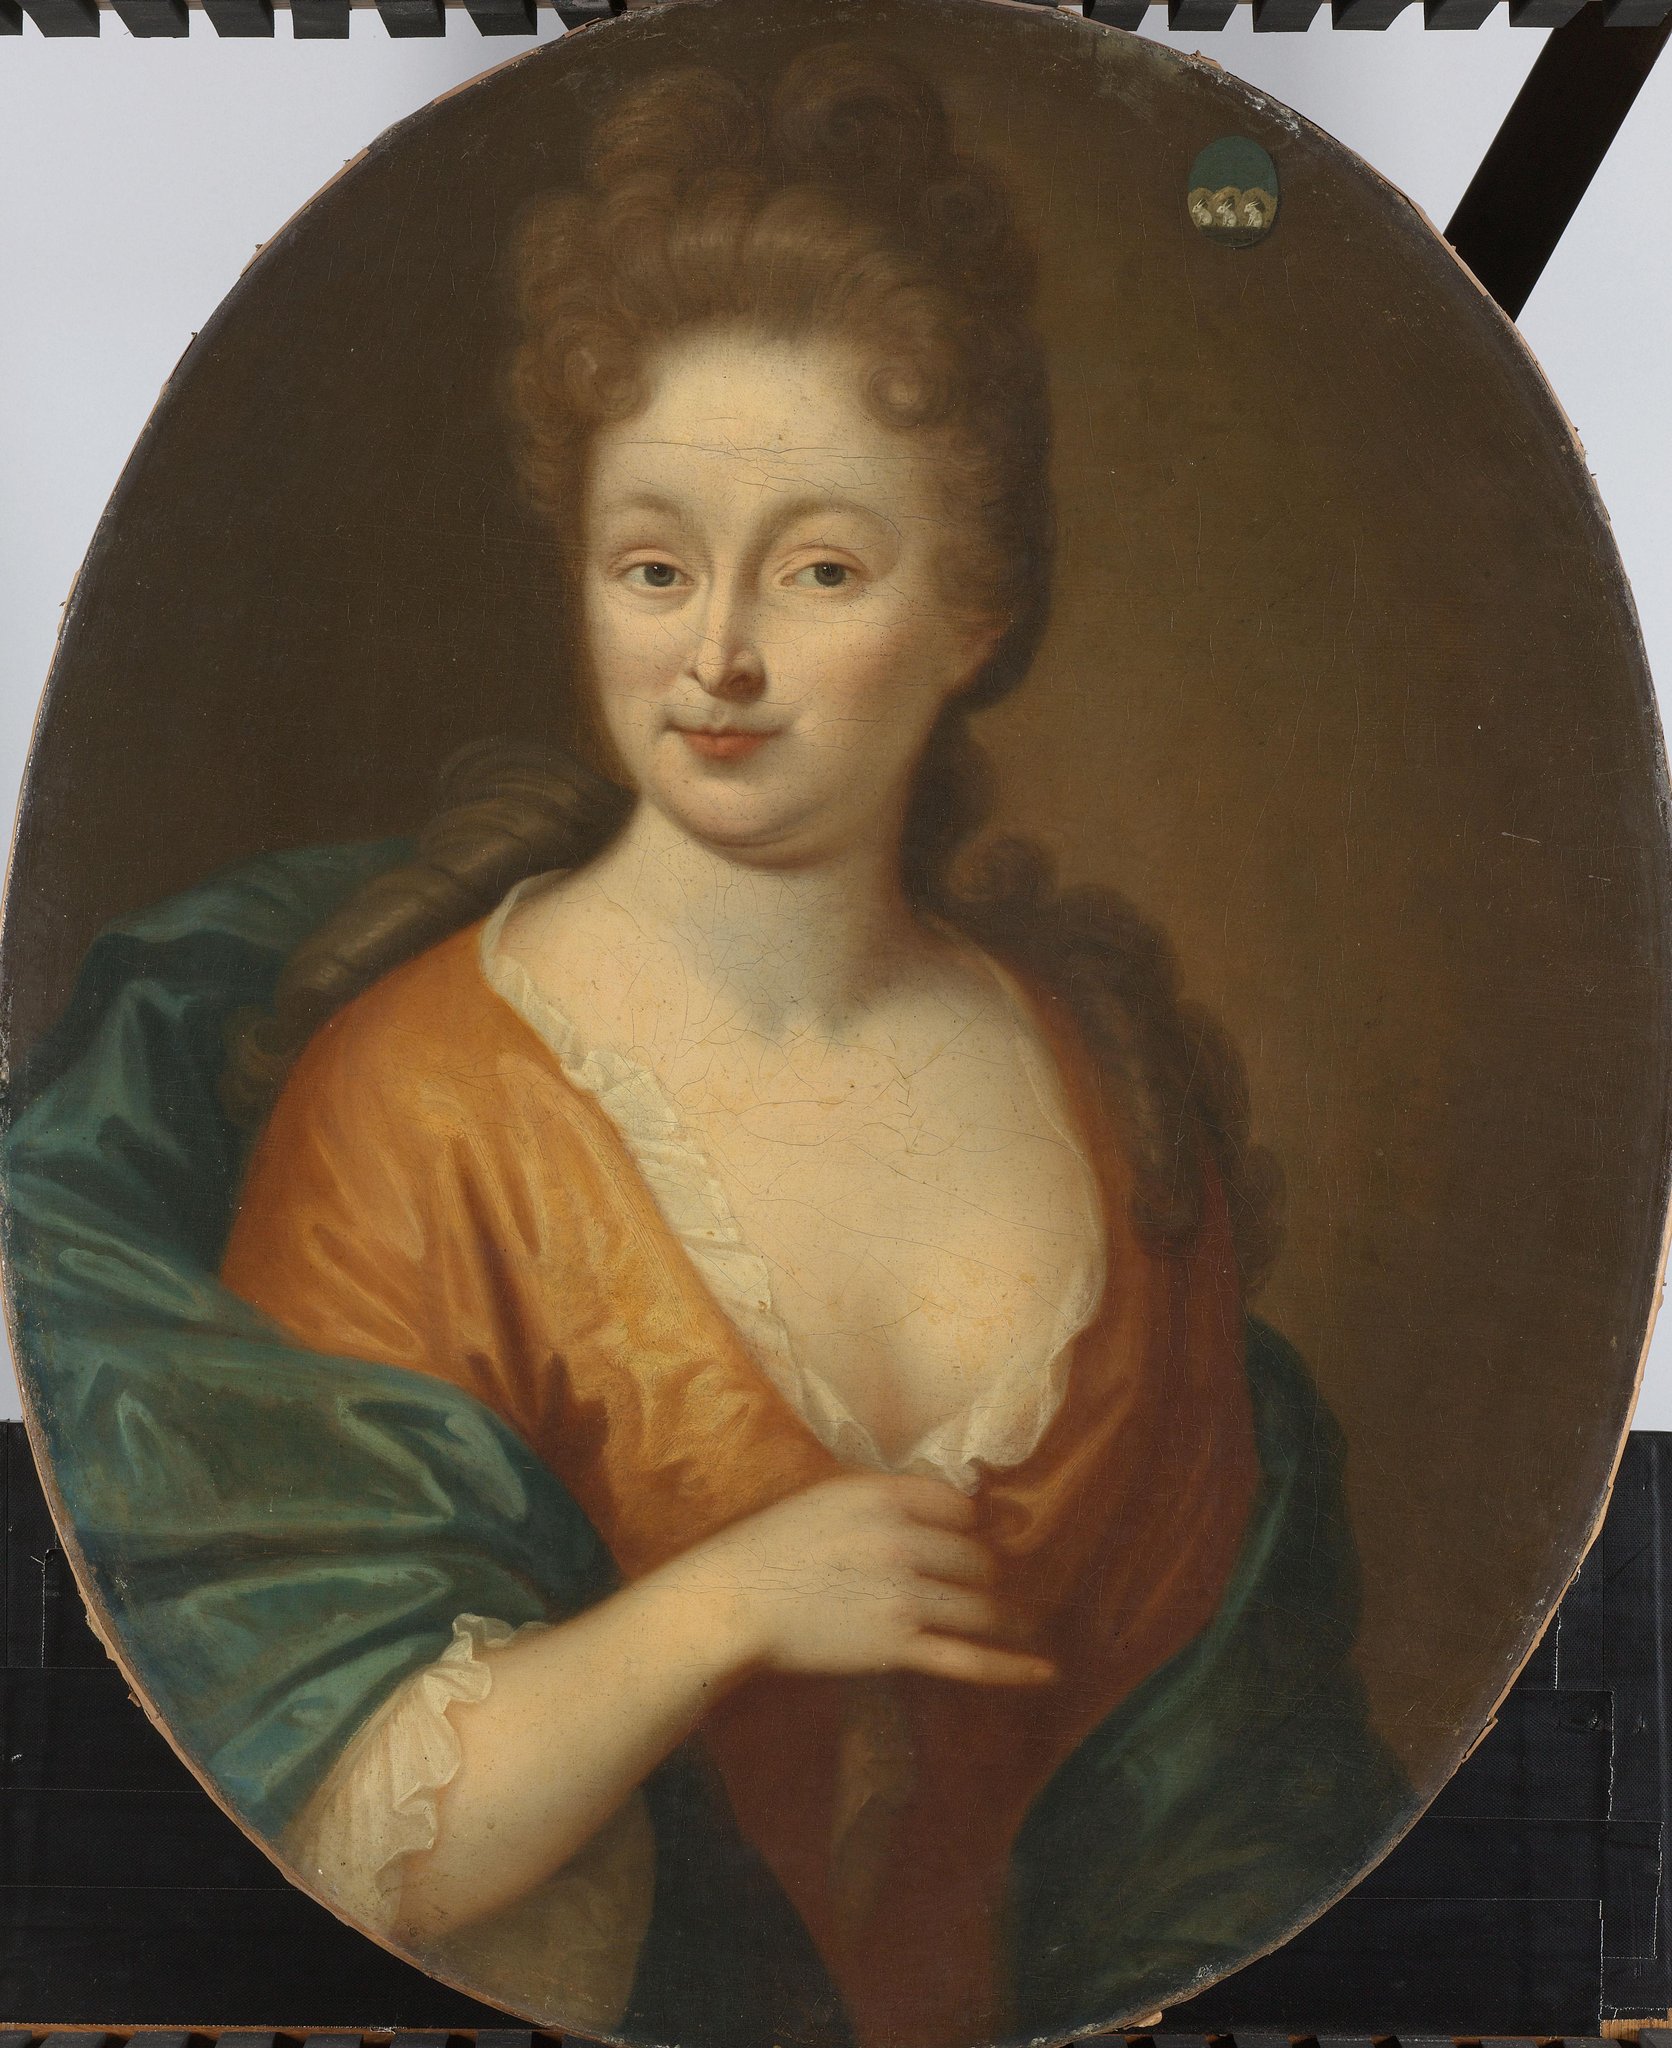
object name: painting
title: Portrait of a Woman, possibly Elisabeth Hollaer, Wife of Theodorus Rijswijk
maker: pieter van der werff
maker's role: draughtsman, painter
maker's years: 1665-1722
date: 1700-1722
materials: canvas, oil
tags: amsterdam, historical persons - bb - woman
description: Attributed to Pieter van der Werff. Portrait of a woman, thought to be Elisabeth Hollaer, wife of Theodorus Rijswijk.